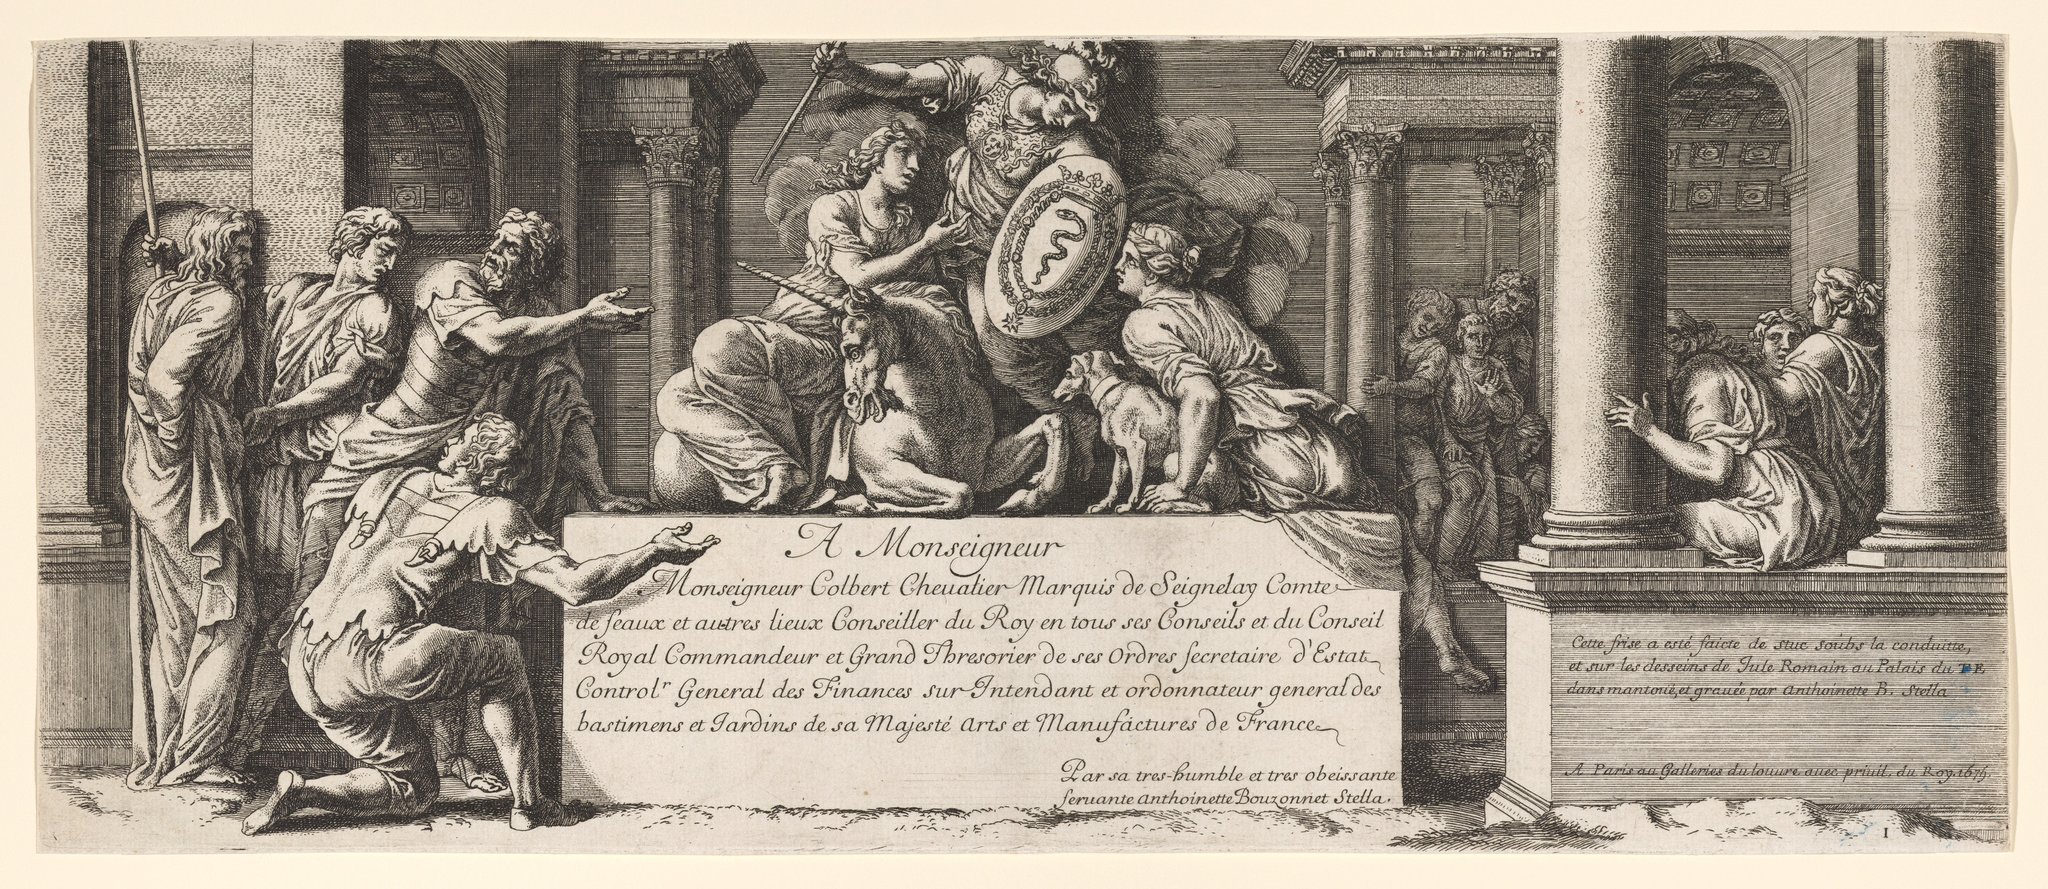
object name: print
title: Friezes after Giulio Romano, in Palazzo del Te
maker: antoinette bouzonnet stella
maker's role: etcher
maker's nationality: french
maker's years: 1641-1676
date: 1675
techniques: etching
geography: france